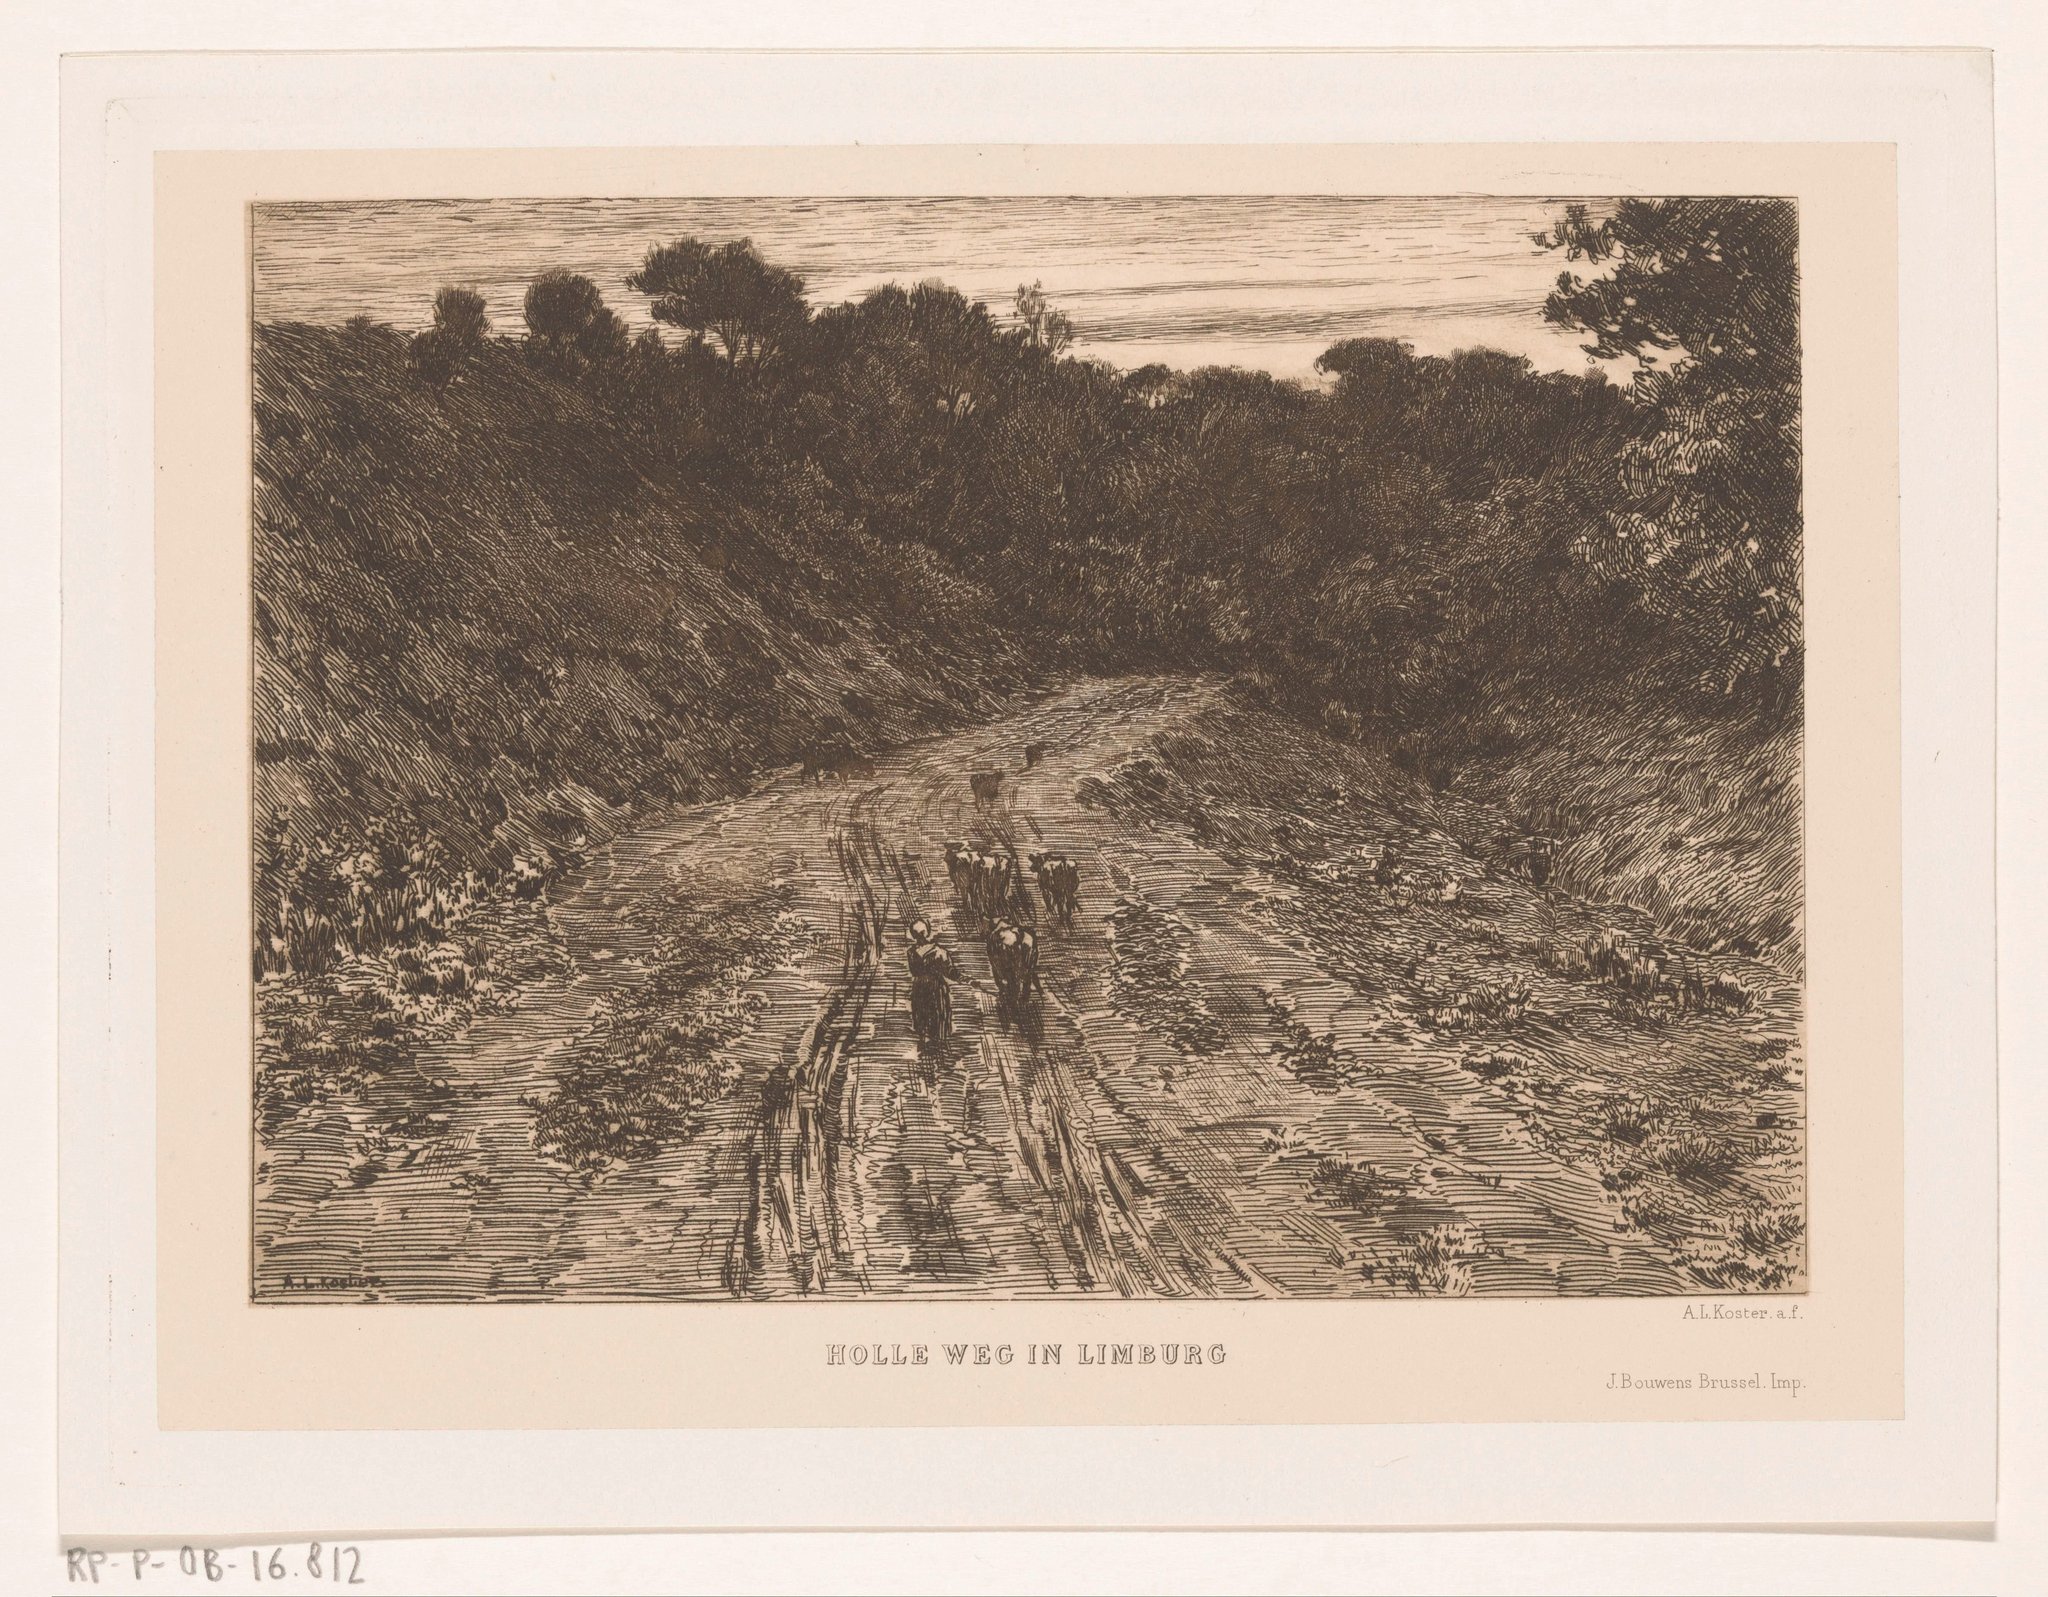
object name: print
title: Holle weg in Limburg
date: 1869-1937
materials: paper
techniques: etching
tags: herding, herdsman, herdswoman, shepherd, shepherdess, cowherd, etc., forest path or lane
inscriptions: collector's mark: Lugt 2228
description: Een figuur drijft een kudde runderen voort over een holle weg in Limburg. De weg is aan weerszijden begroeid met struiken en bomen.